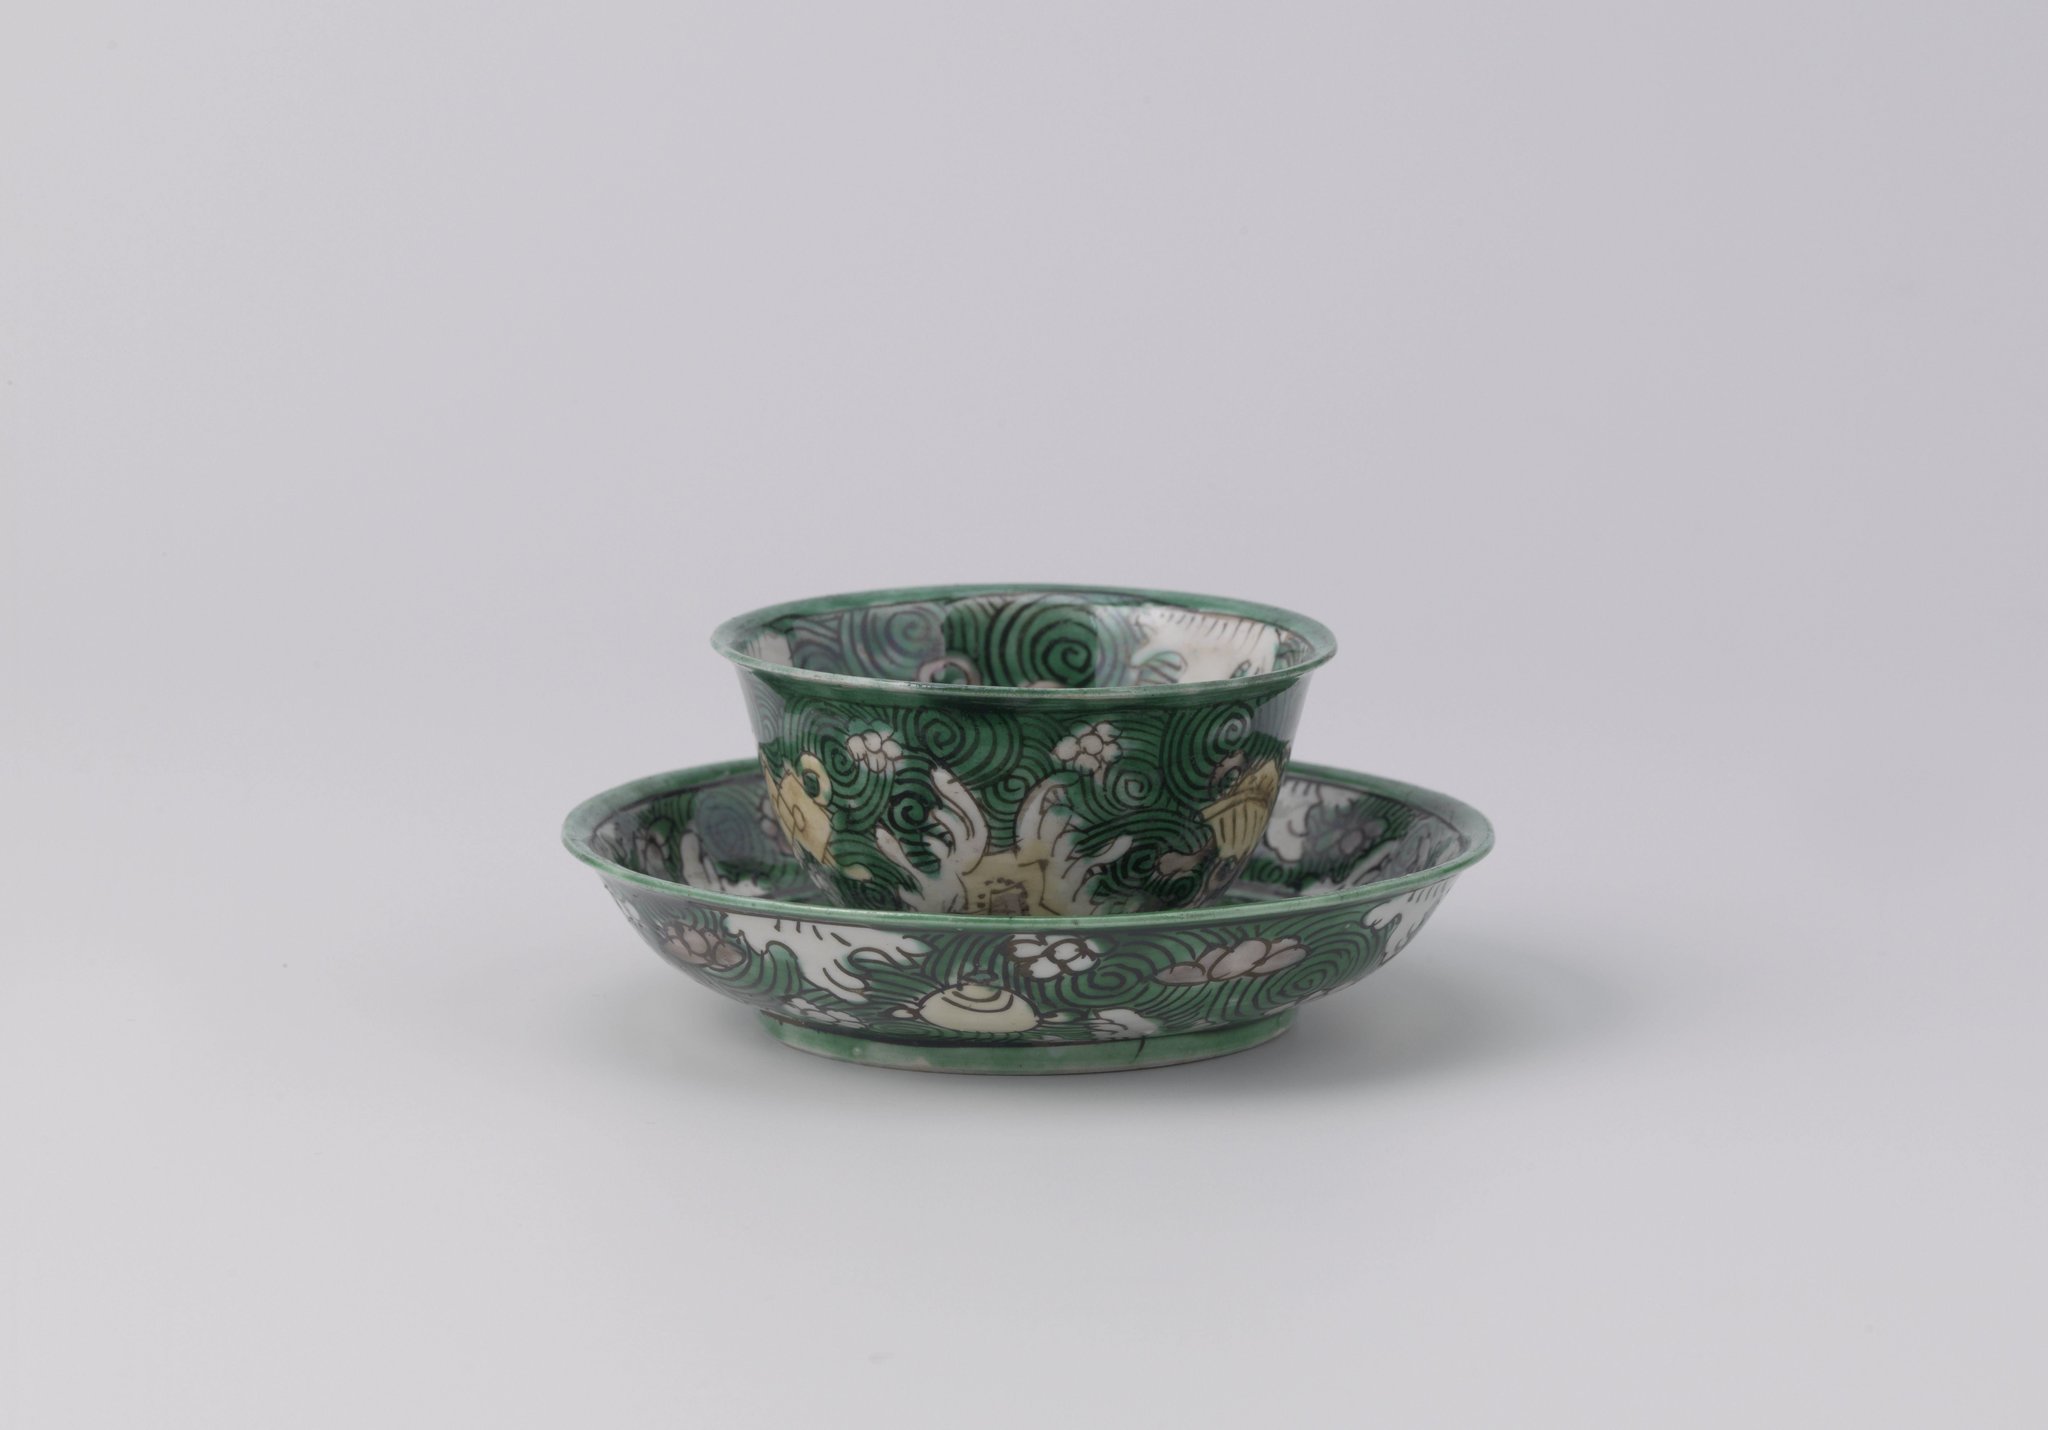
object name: kop en schotel, kop en schotel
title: Cup and saucer with precious objects on a green ground with cloud motifs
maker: Anonymous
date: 1675-1699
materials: cobalt, glaze, paint, porcelain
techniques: firing, turning, vitrification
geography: china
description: Kop en schotel van porselein, beschilderd op biscuit in groen, geel, aubergine en zwart. De schotel is aan de voor- en achterzijde (binnen de voetring uitgezonderd) bedekt met een wolkmotief op een groene grond; op dit motief kostbaarheden (munt, parel, ruit, artemisiablad) en gelukssymbolen (schelp). Kop met dezelfde decoratie. Email sur biscuit met famille verte kleuren.